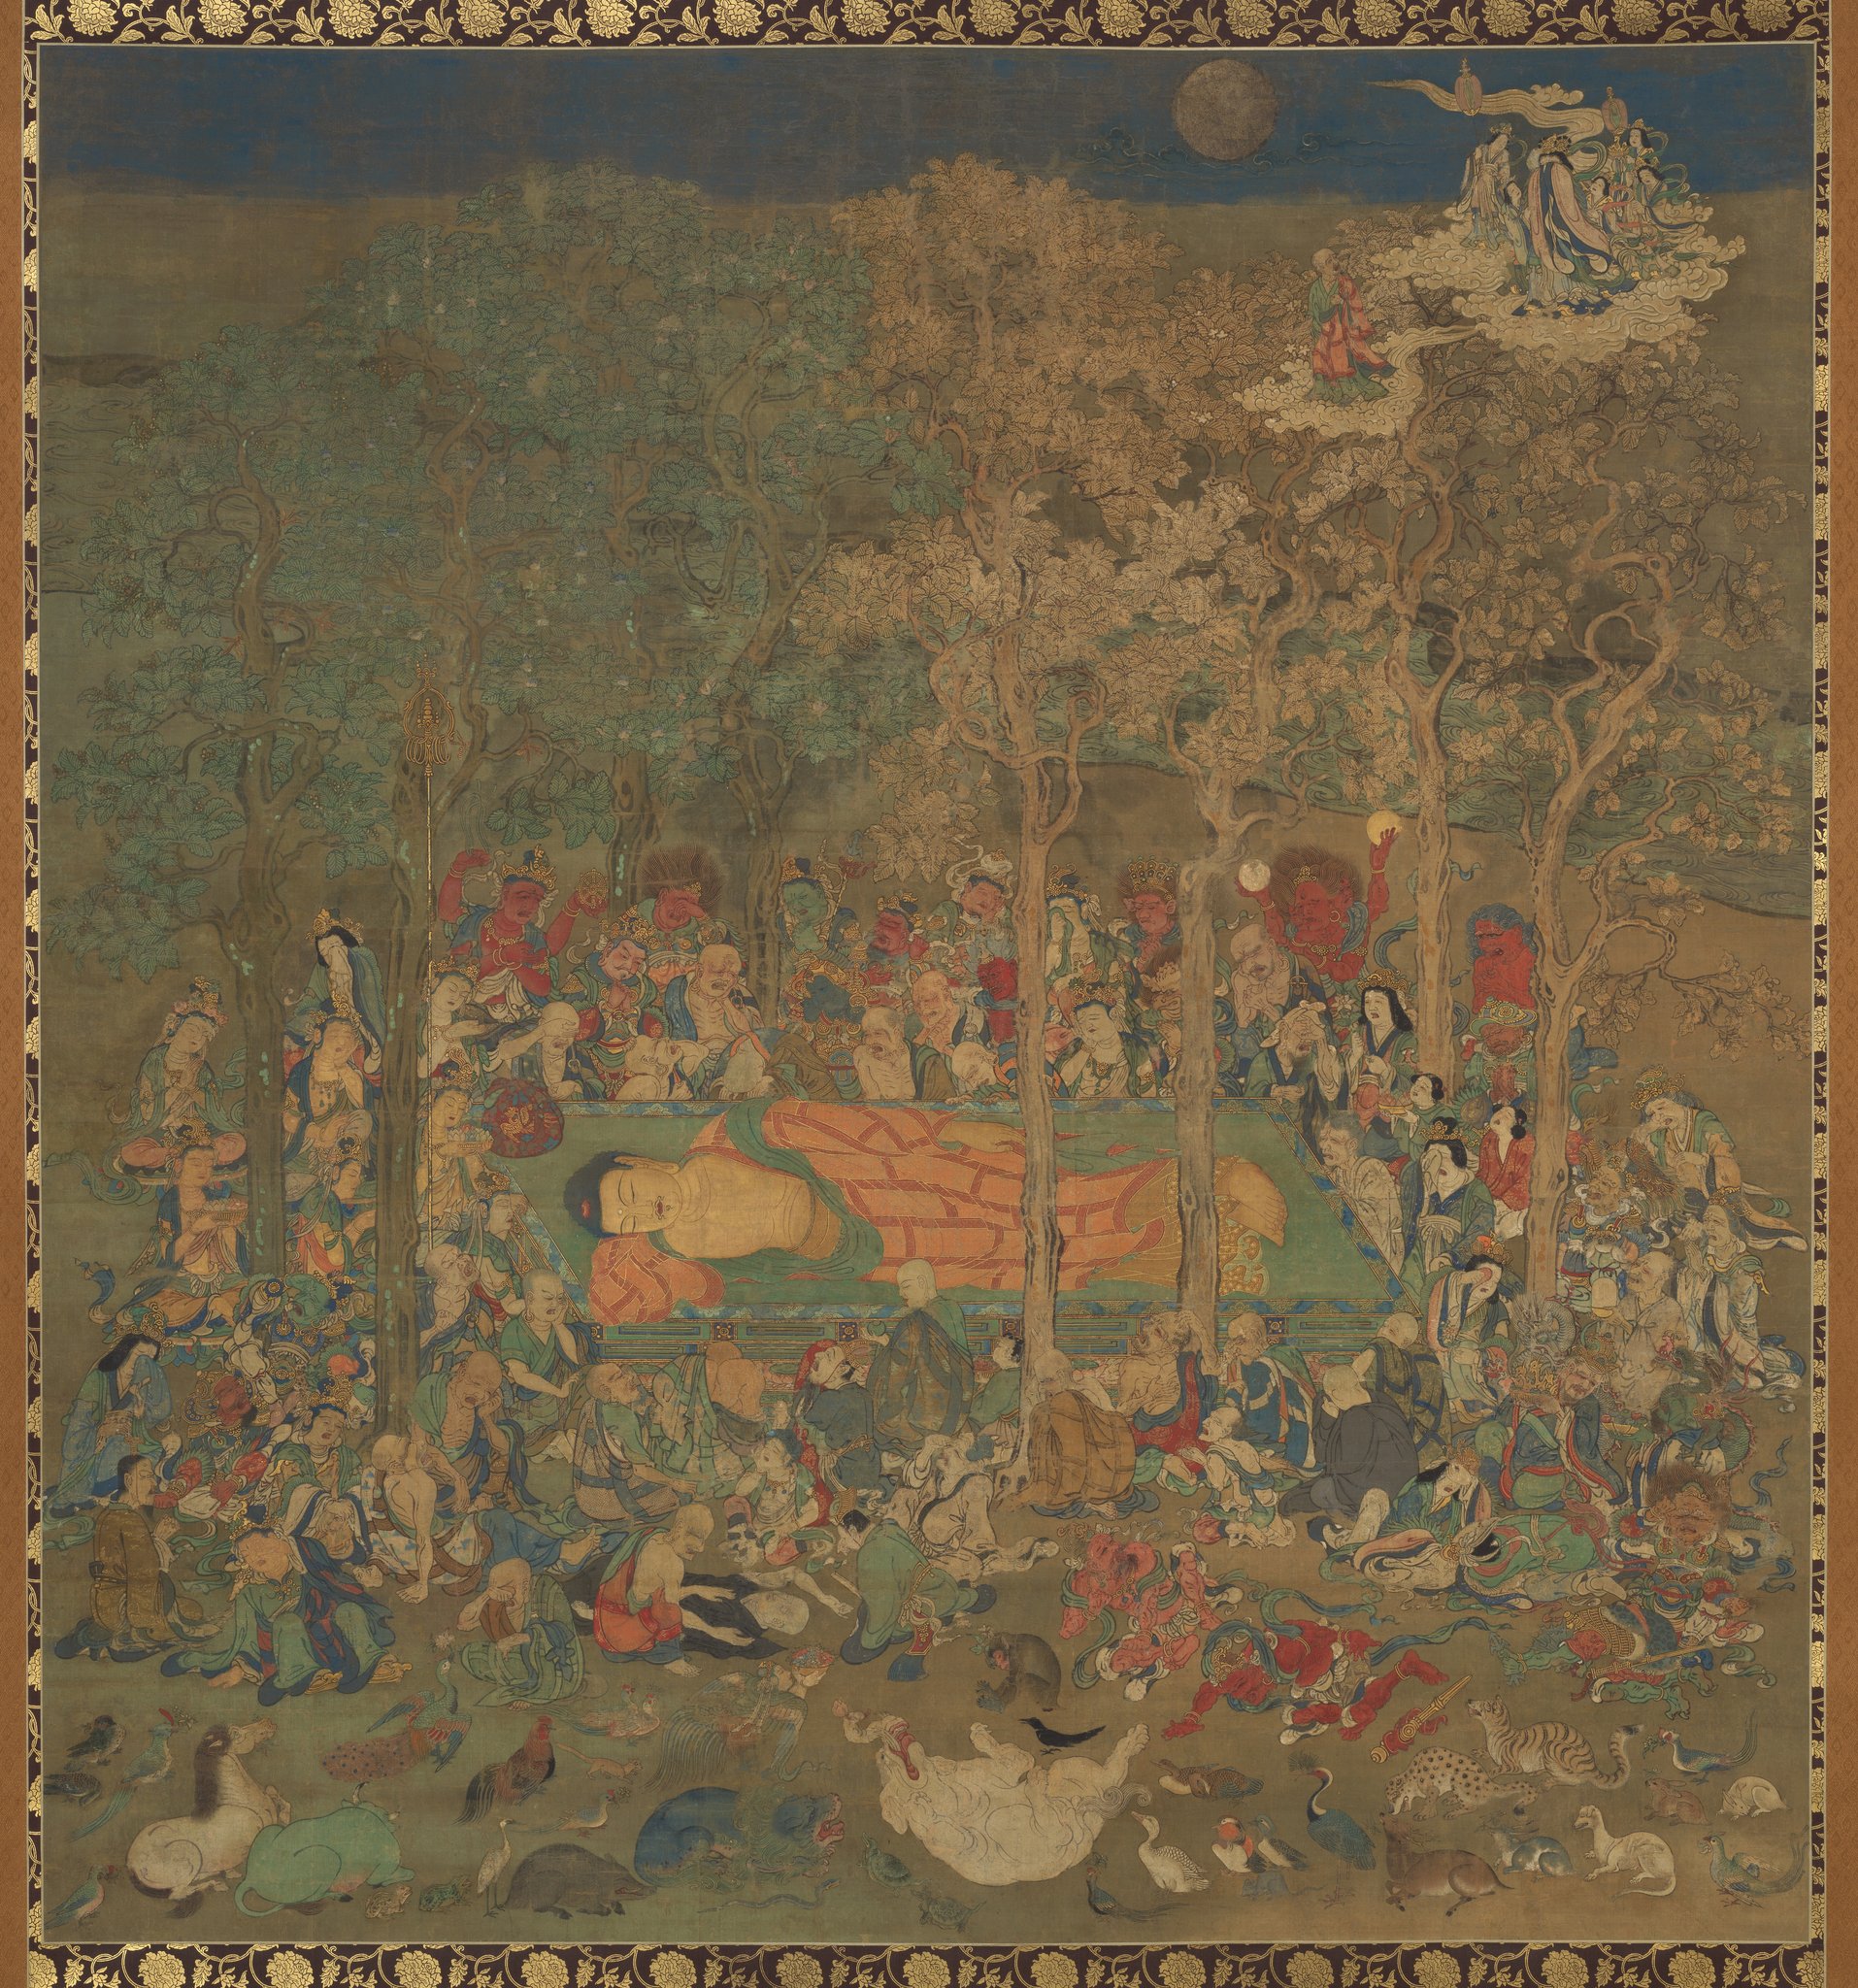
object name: hanging scroll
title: Death of the Historical Buddha (Nehan-zu)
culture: japanese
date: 1301-1400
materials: gold, ink, silk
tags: birds,sadness,men,women,elephants,horses,monkeys,buddha,death